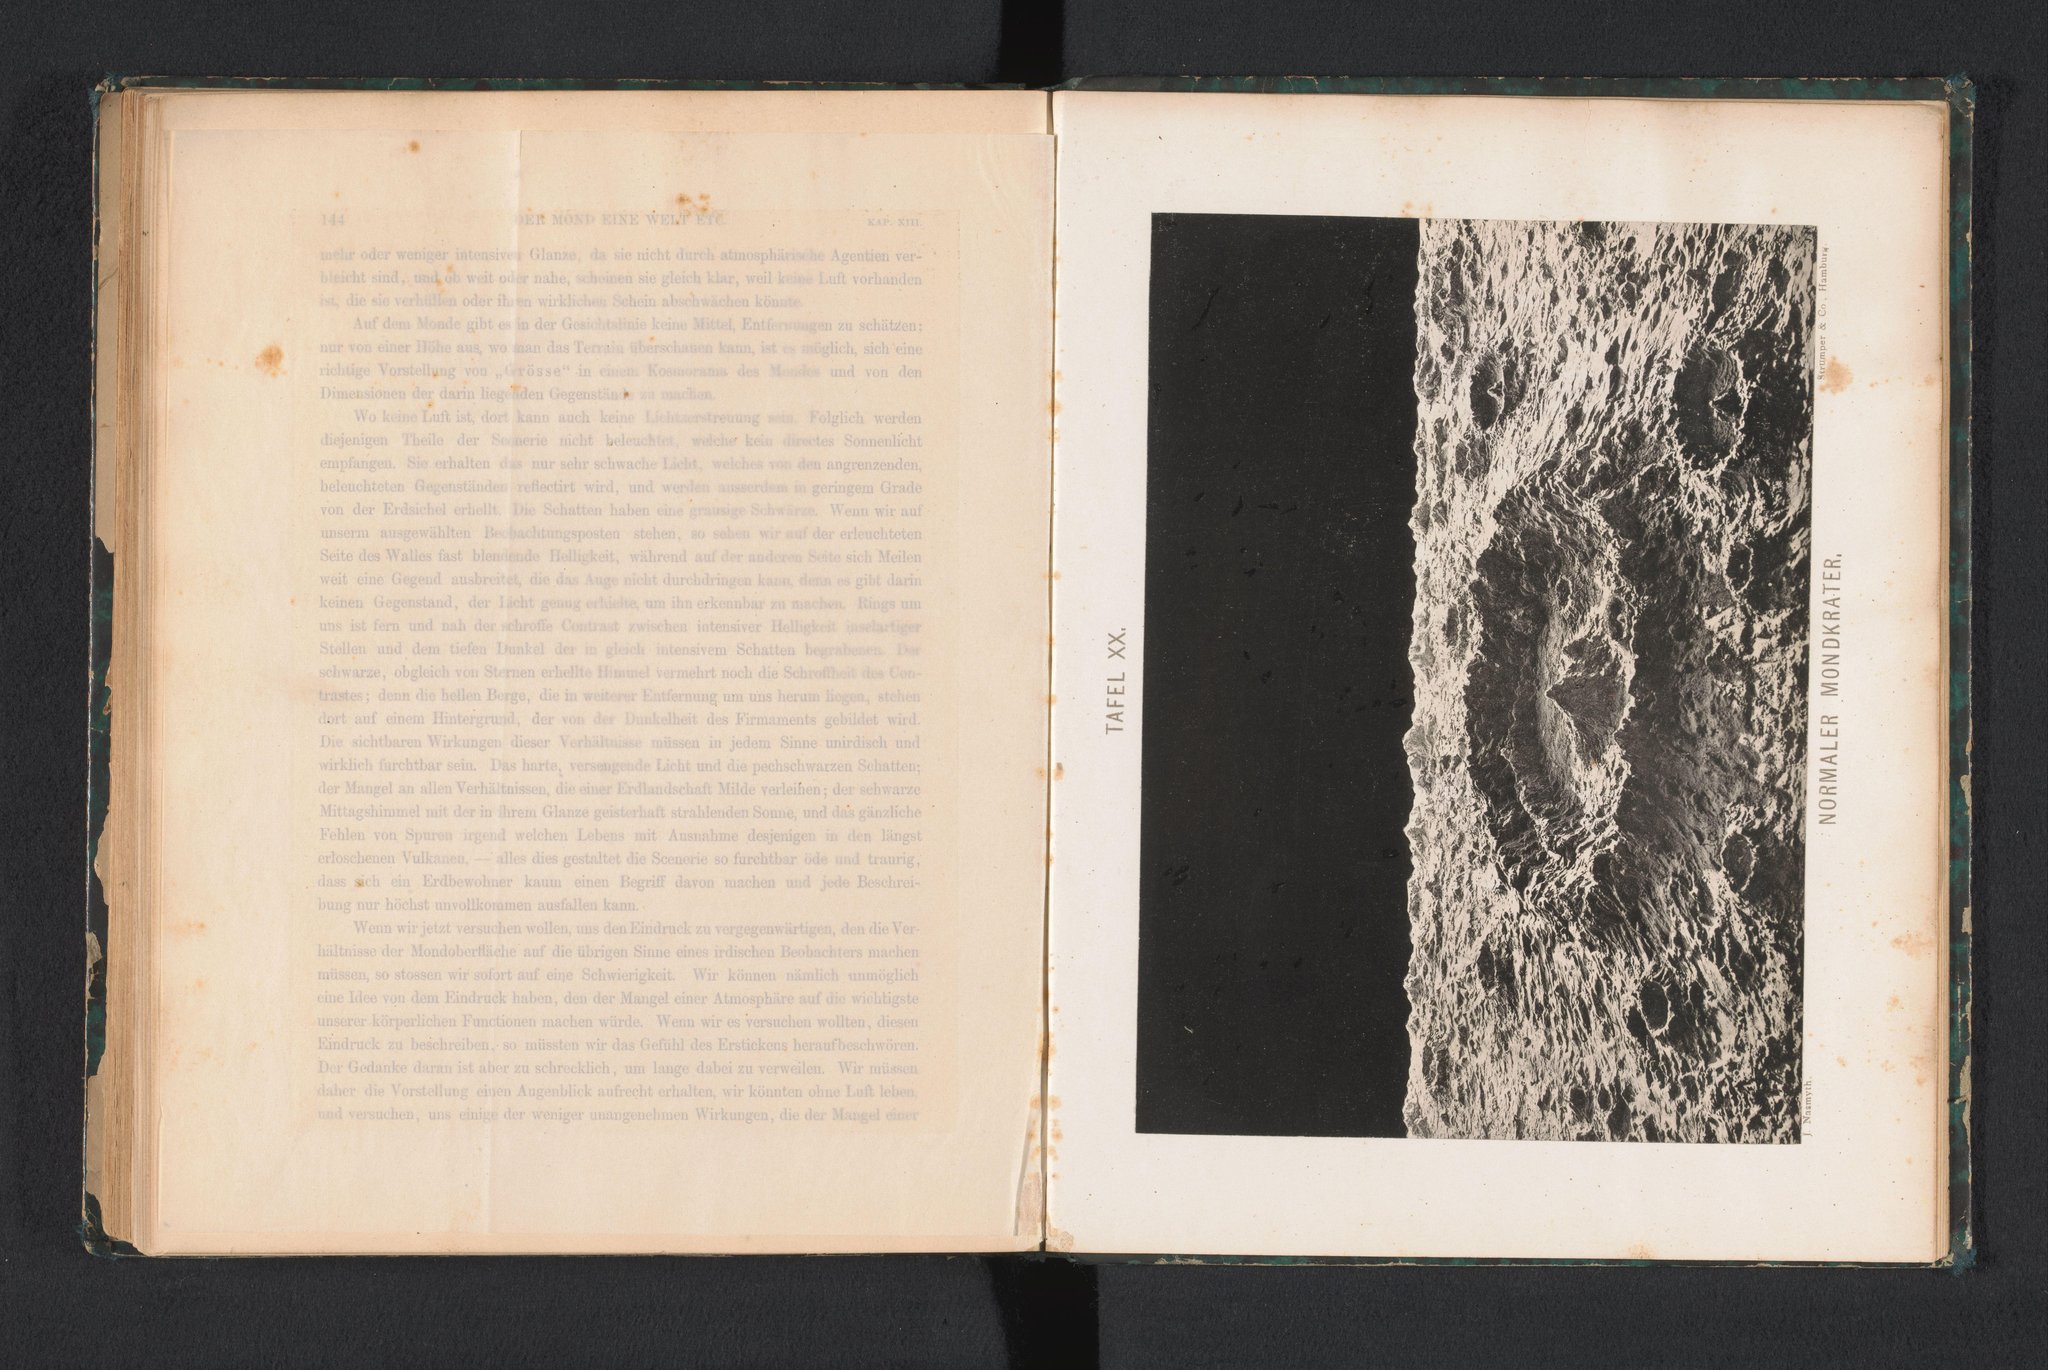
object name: page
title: Gipsmodel van een maankrater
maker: james nasmyth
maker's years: 1808-1890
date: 1863-1873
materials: paper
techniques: photograph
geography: london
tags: surface of the moon, moon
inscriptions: number